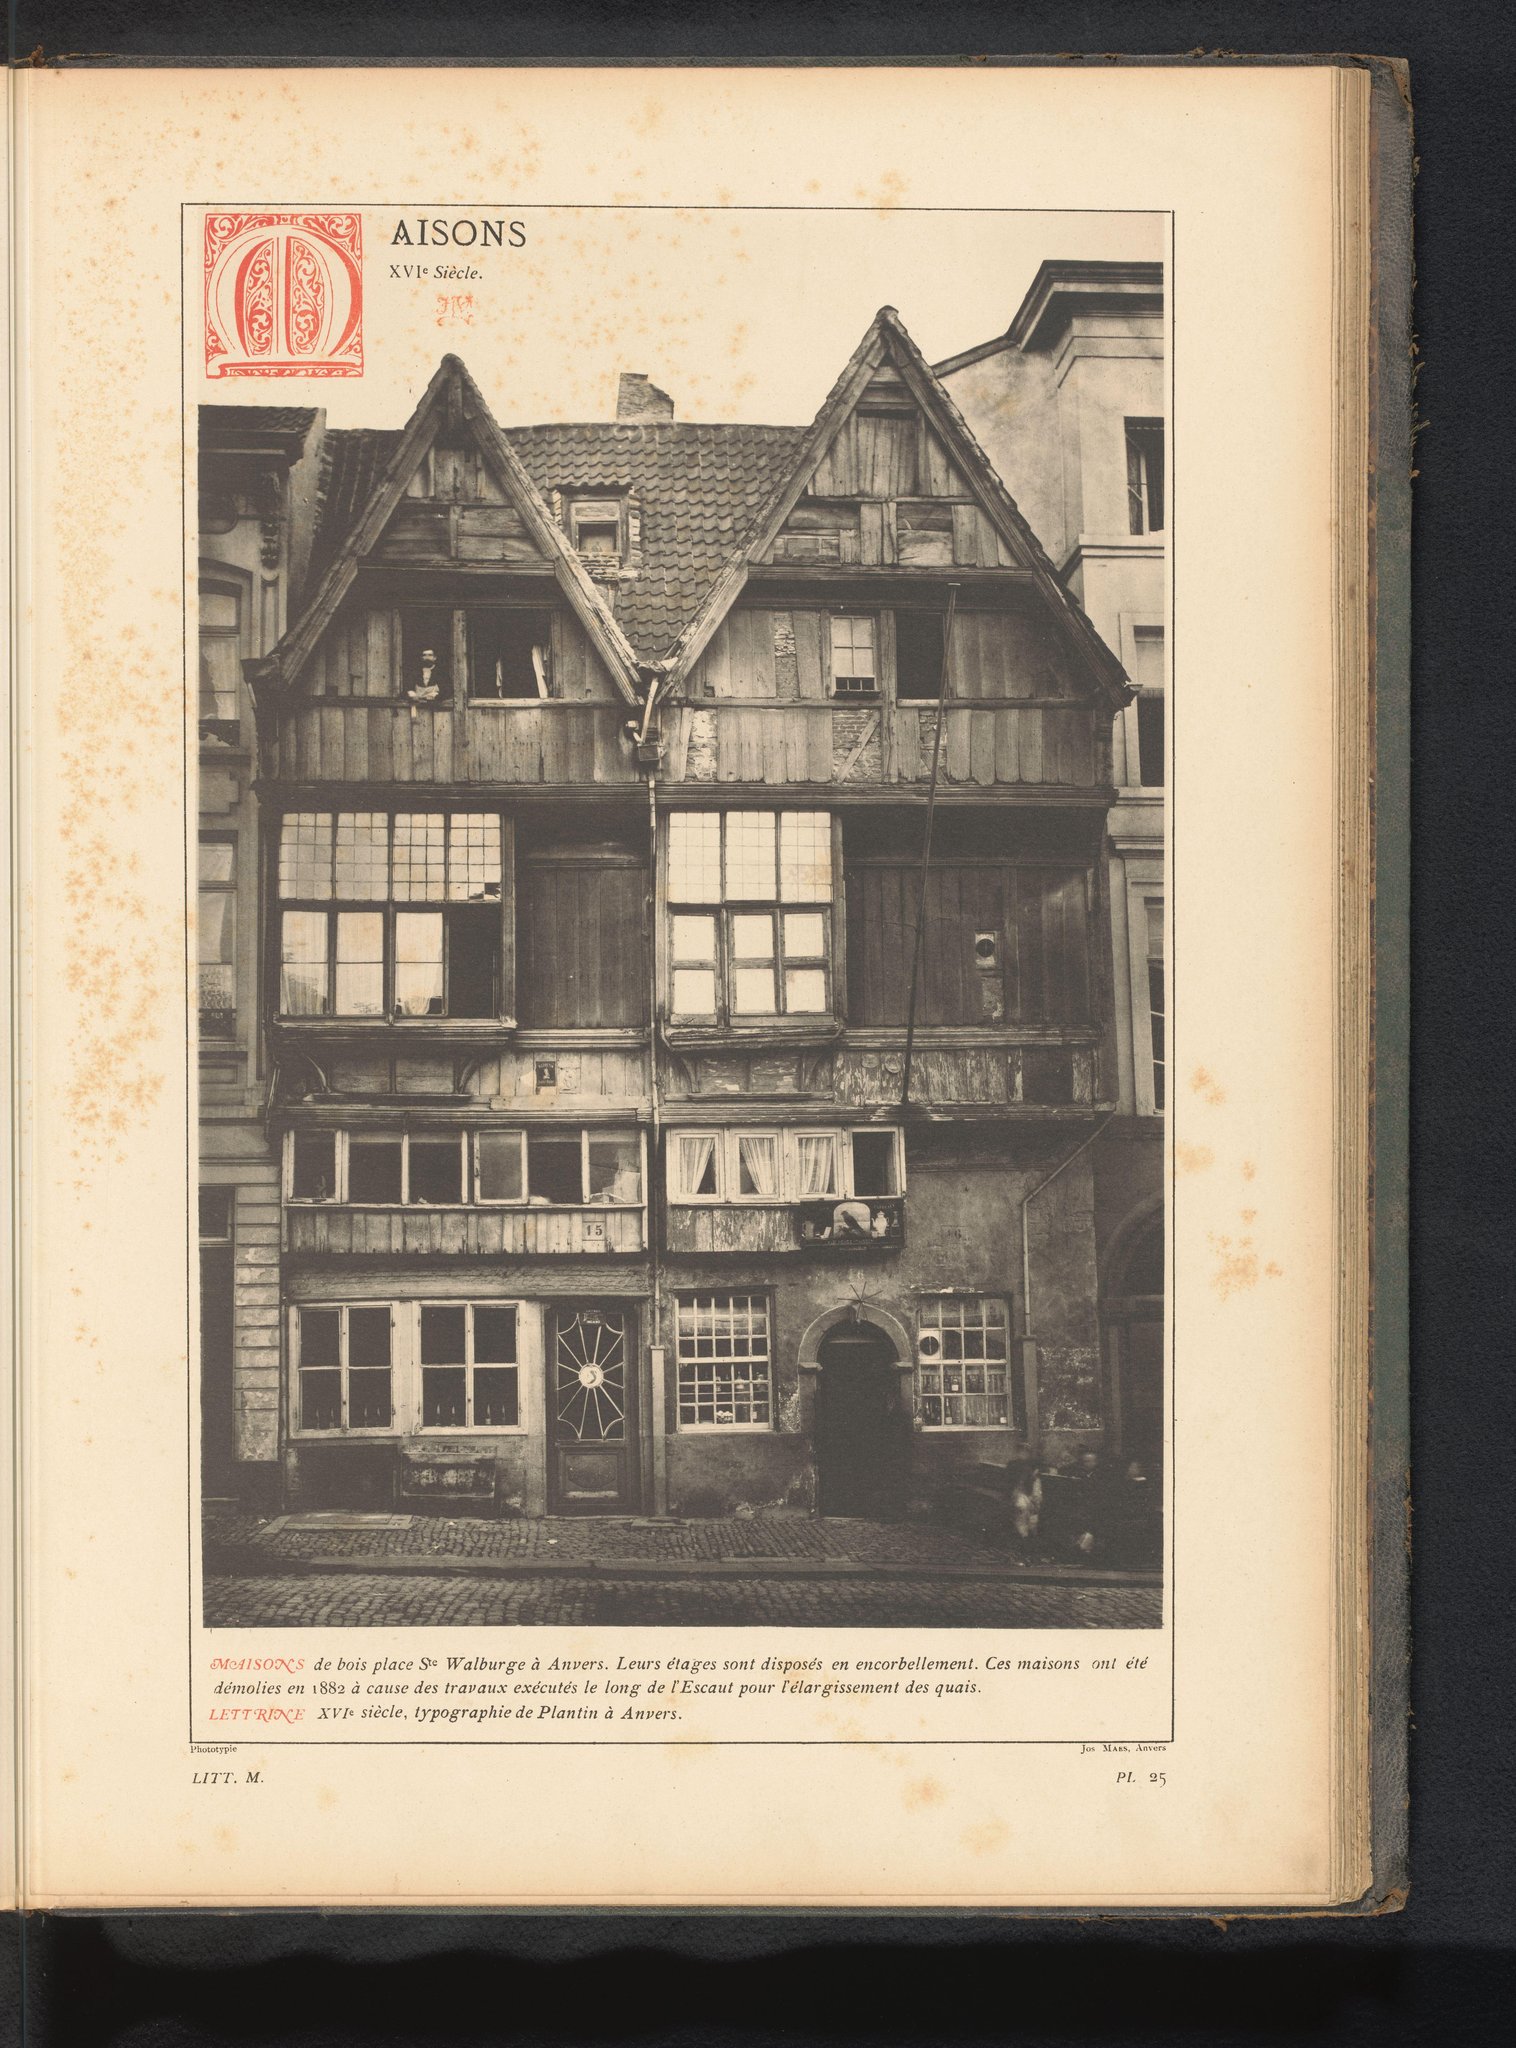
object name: photomechanical print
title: Maisons, XVIe Siècle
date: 1875-1880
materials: paper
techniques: photograph, photolithography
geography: antwerp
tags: civic architecture; edifices; dwellings, antwerp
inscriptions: inscription: ‘MAISONS de bois (...)’, monogram: ‘JJvY’, inscription: ‘LITT. M. - PL. 25’